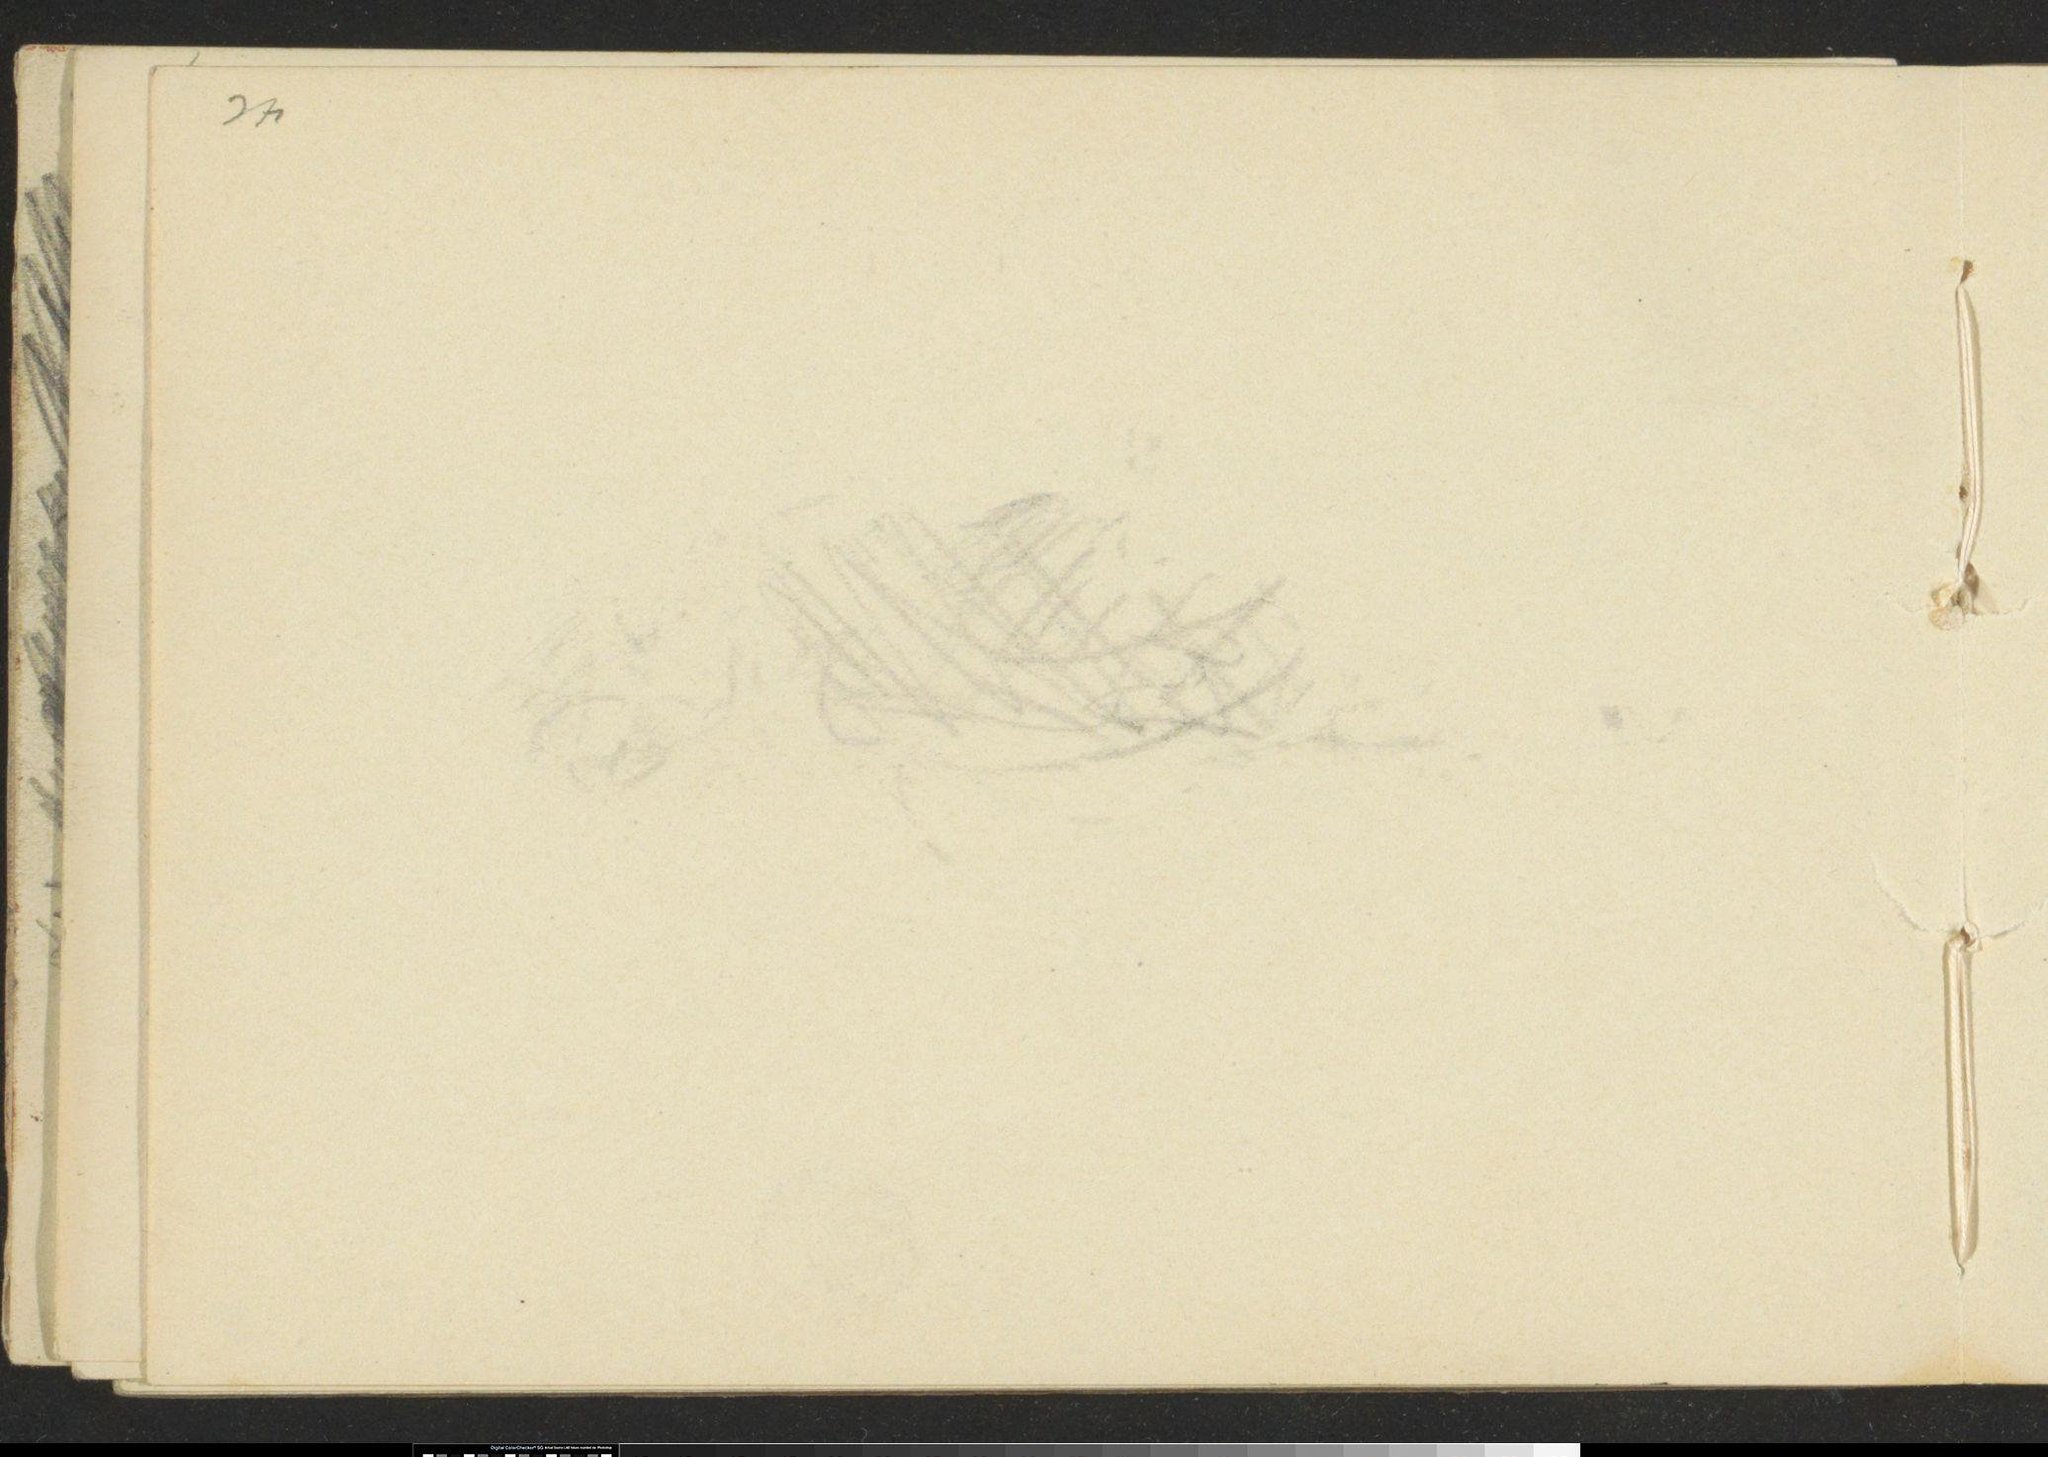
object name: sketchbook leaf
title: Abklatsch van de potloodtekening op blad 6 recto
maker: isaac israels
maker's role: draughtsman, painter, print maker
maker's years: 1865-1934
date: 1875-1934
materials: paper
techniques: printmaking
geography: the hague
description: Blad 5 verso uit schetsboek LXV met 27 bladen.